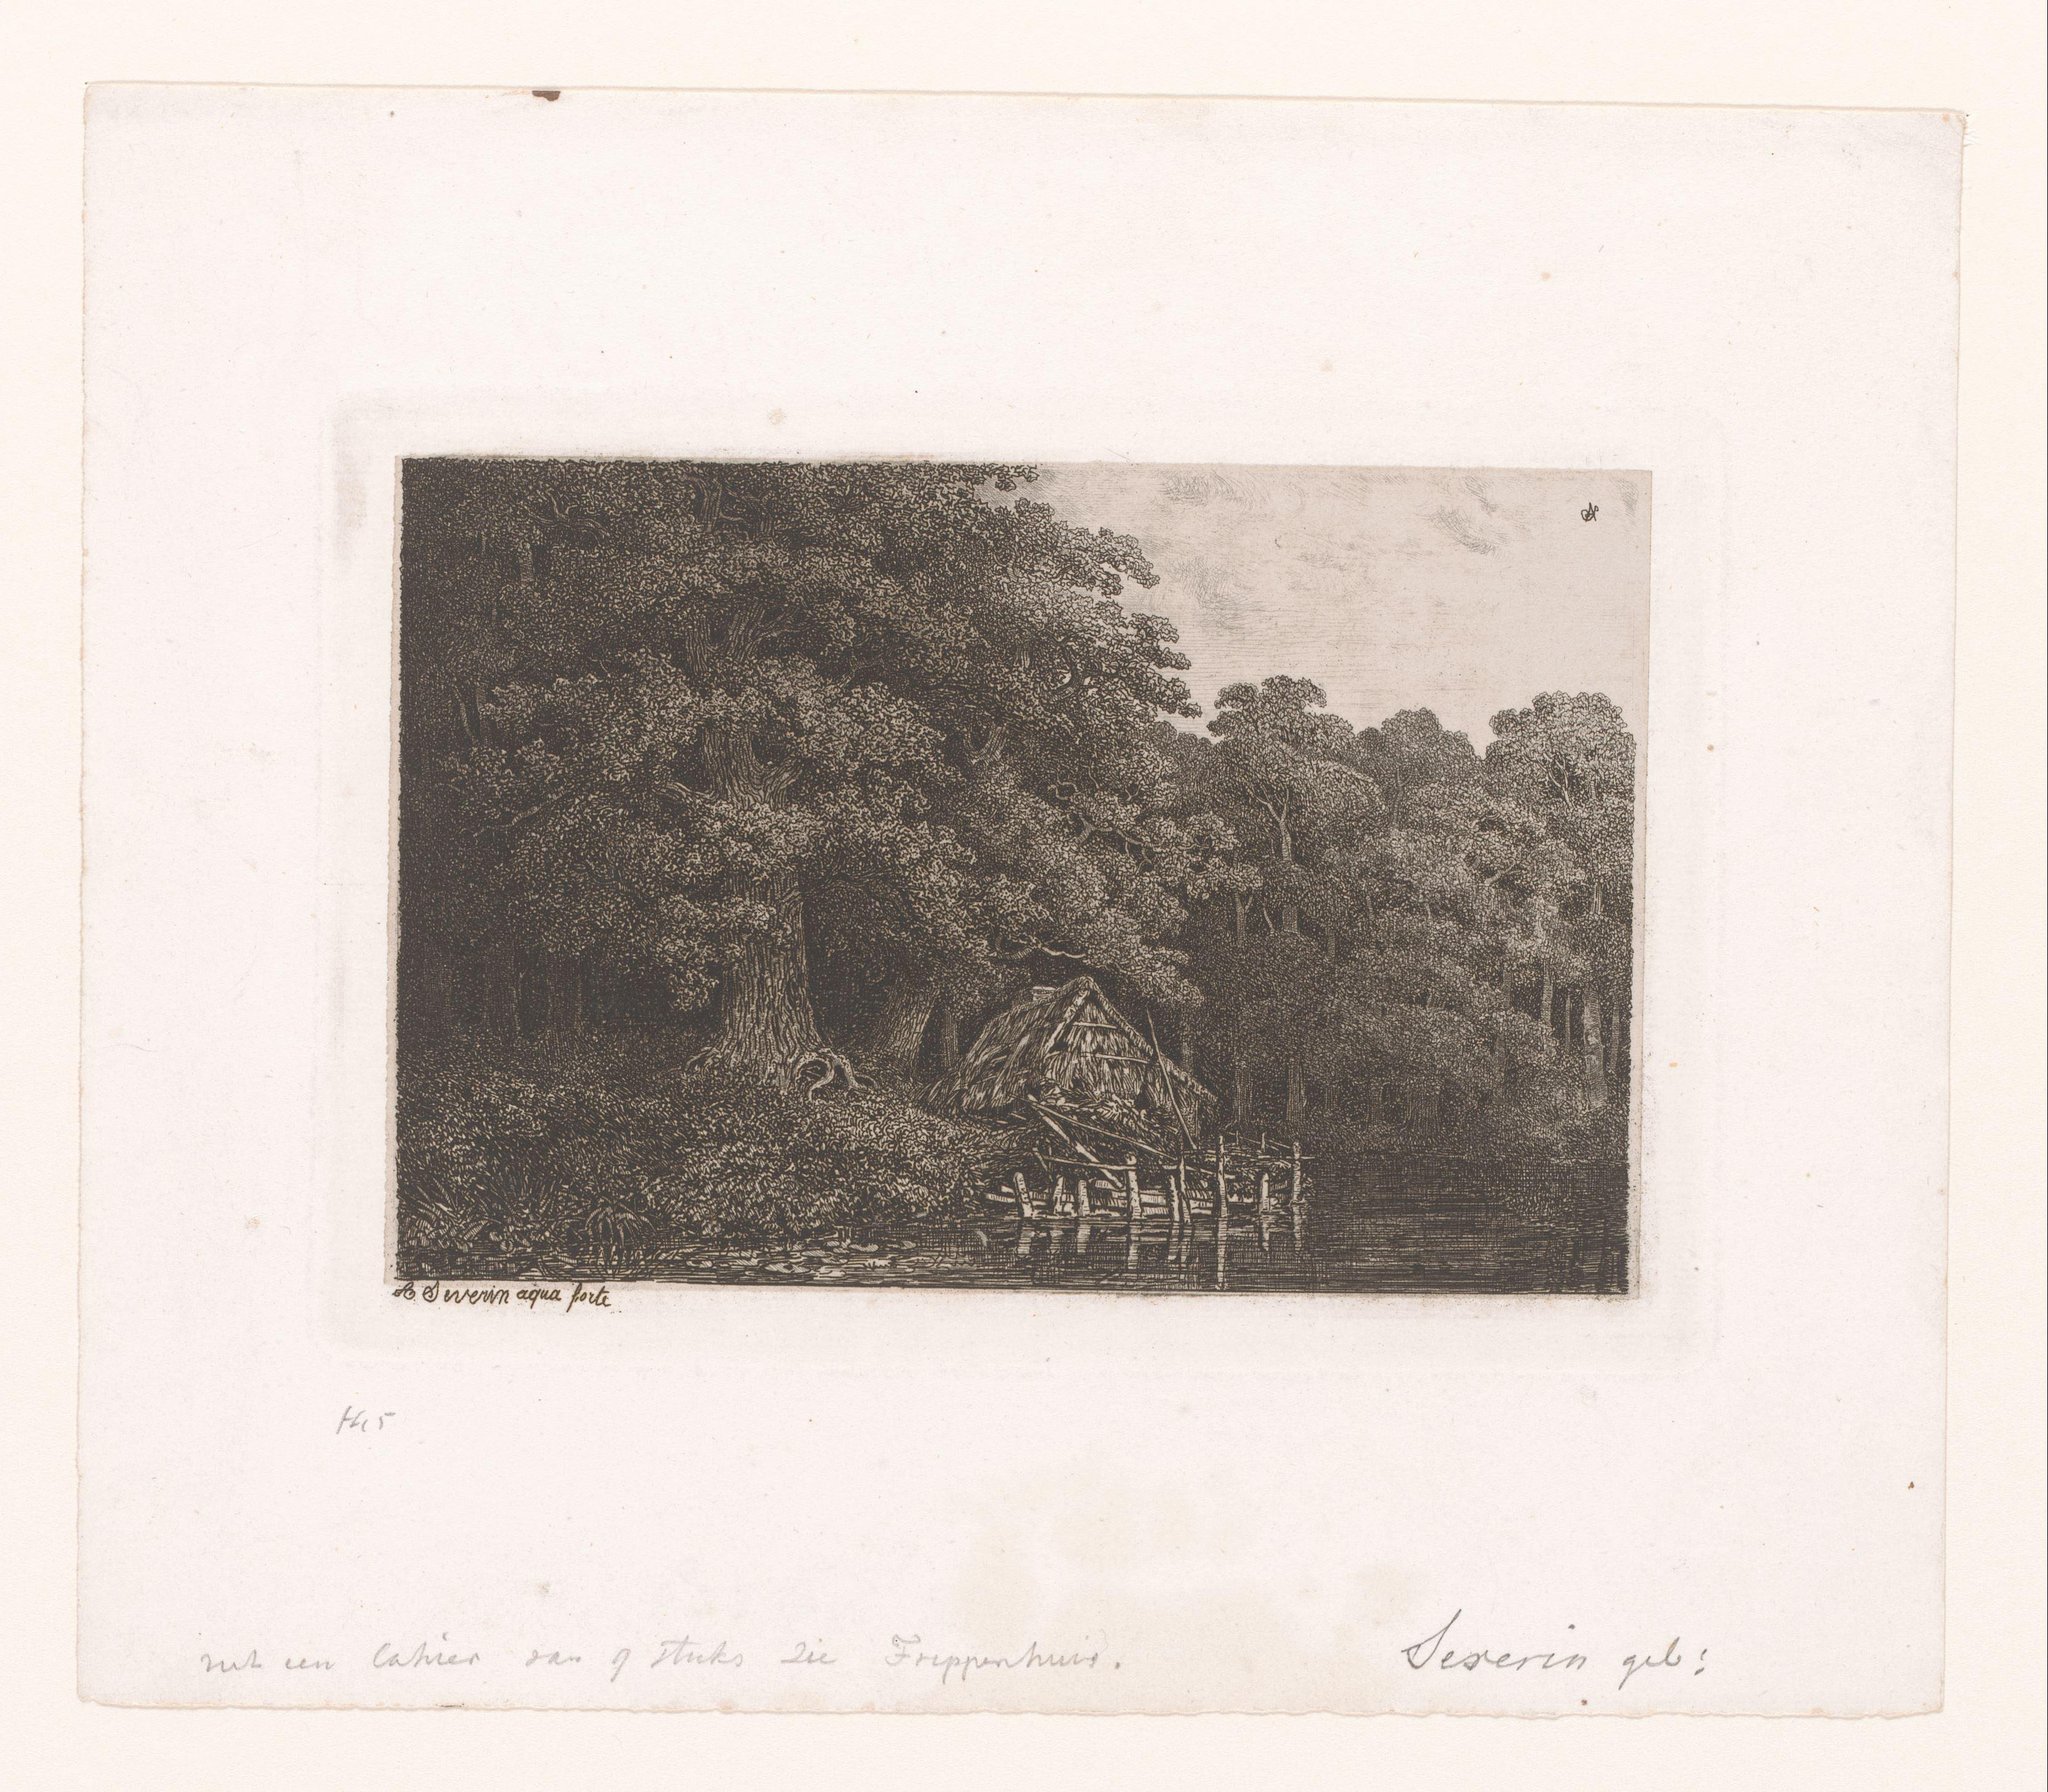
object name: print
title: Negen landschappen door Antoine Severin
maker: antoine severin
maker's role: print maker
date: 1851-1852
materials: paper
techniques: drypoint, etching, intaglio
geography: brussels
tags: lake, forest, wood, hut, cabin, lodge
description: Prent maakt deel uit van een serie van negen prenten.